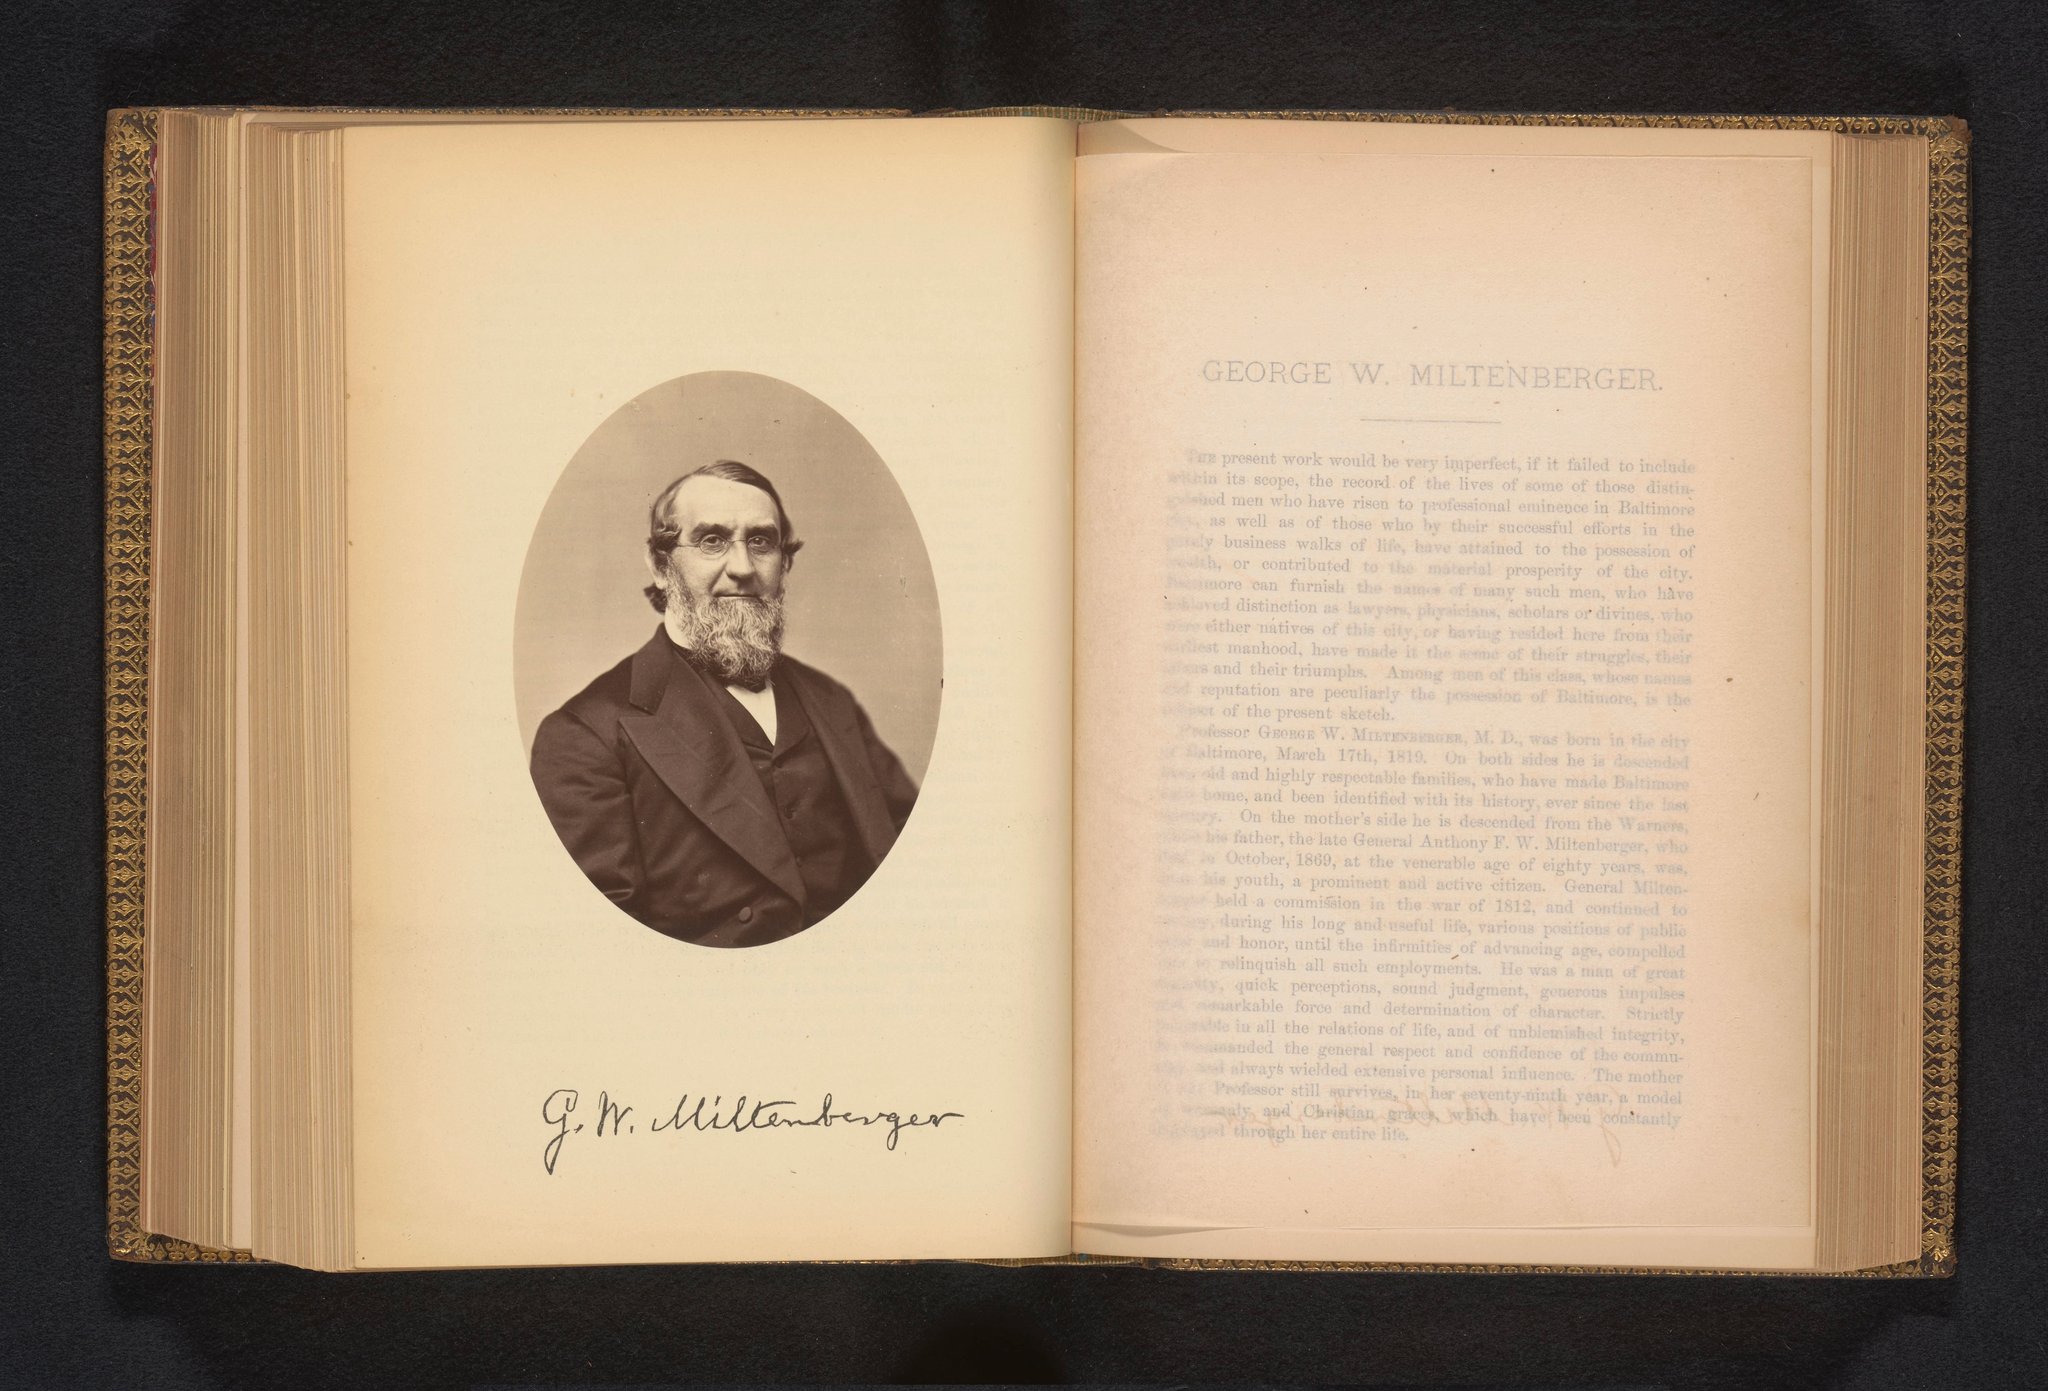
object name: photograph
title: Portret van George W. Miltenberger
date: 1866-1871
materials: photographic support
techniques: albumen print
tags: historical persons